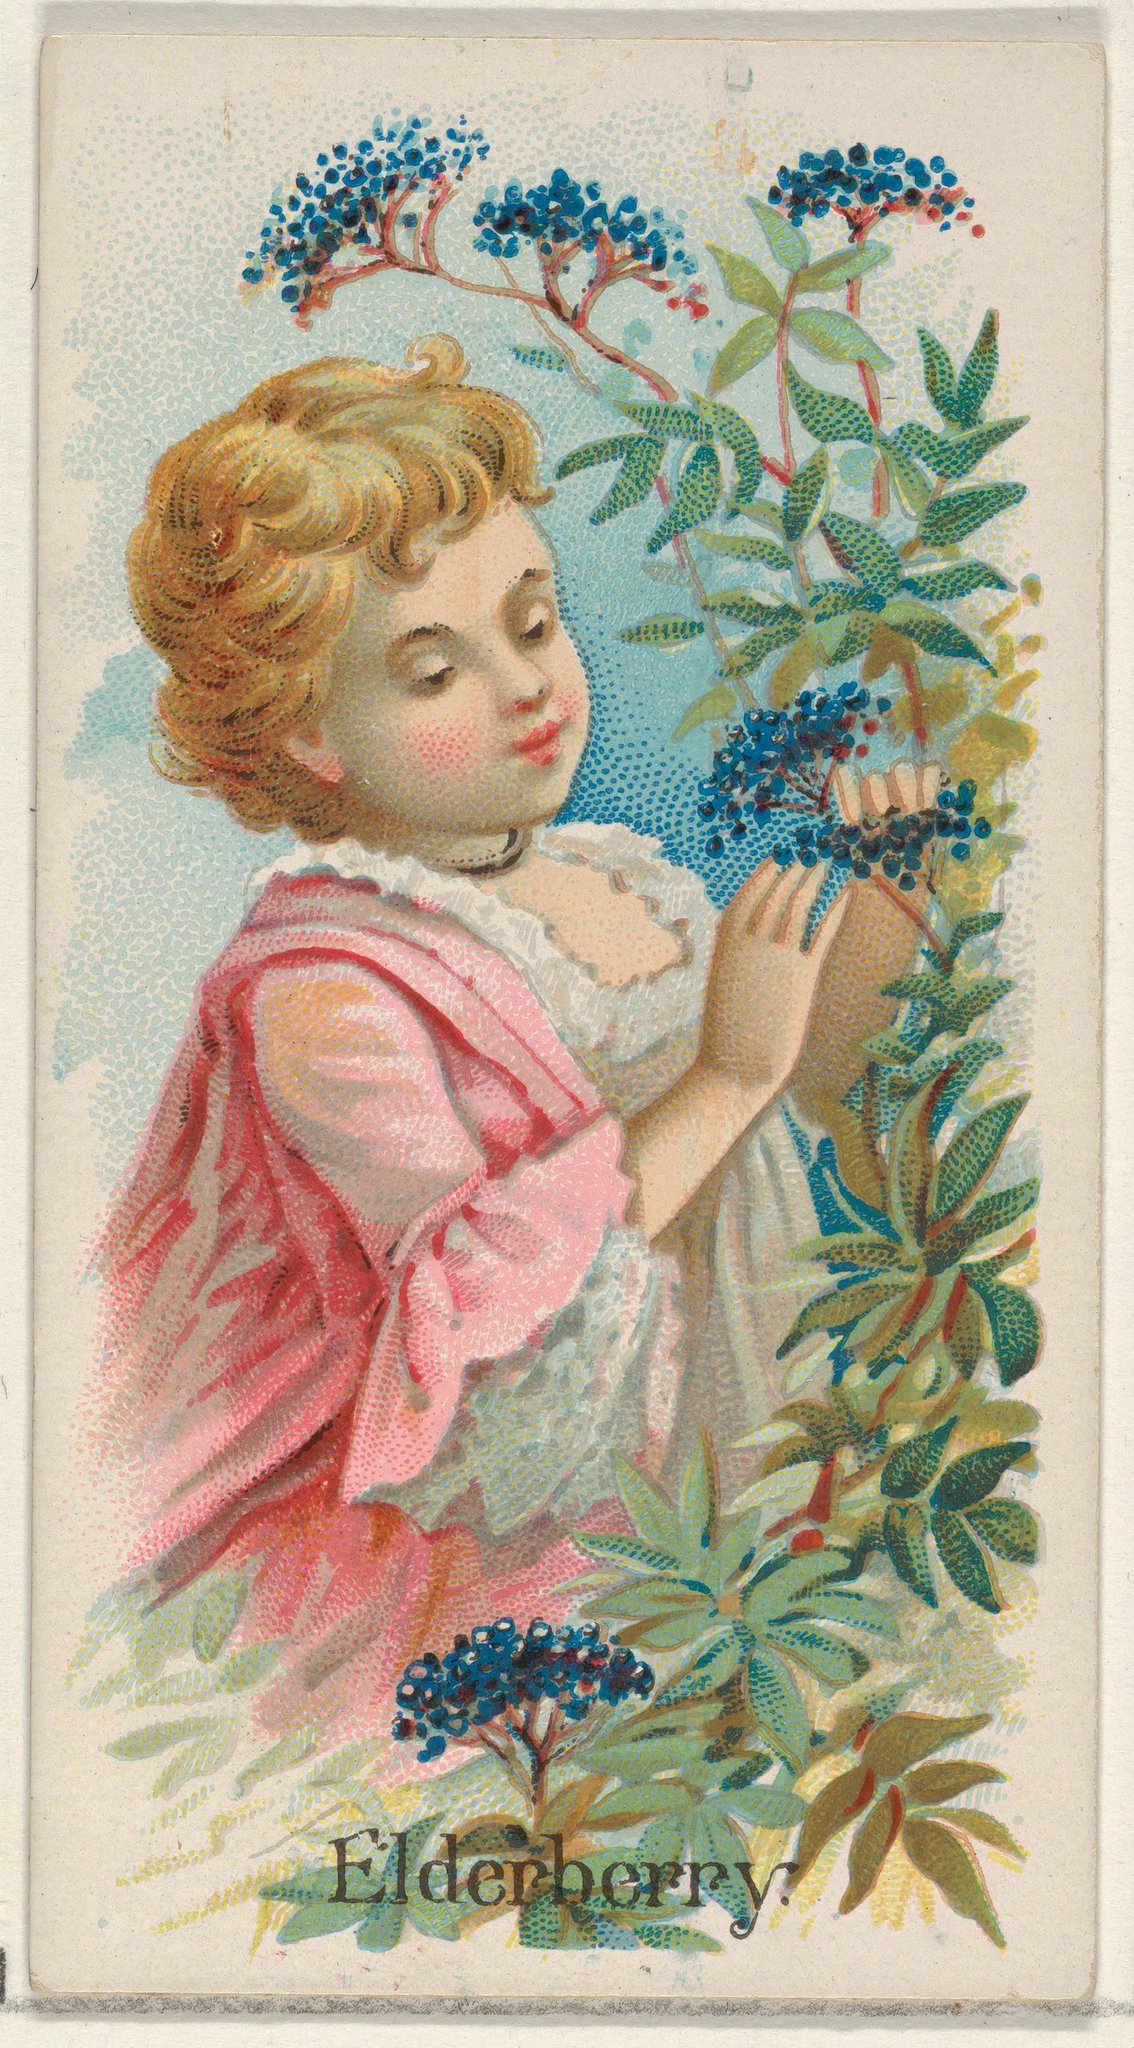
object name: print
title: Elderberry, from the Fruits series (N12) for Allen & Ginter Cigarettes Brands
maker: allen & ginter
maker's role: publisher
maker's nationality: american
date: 1891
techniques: color lithograph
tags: fruit,girls